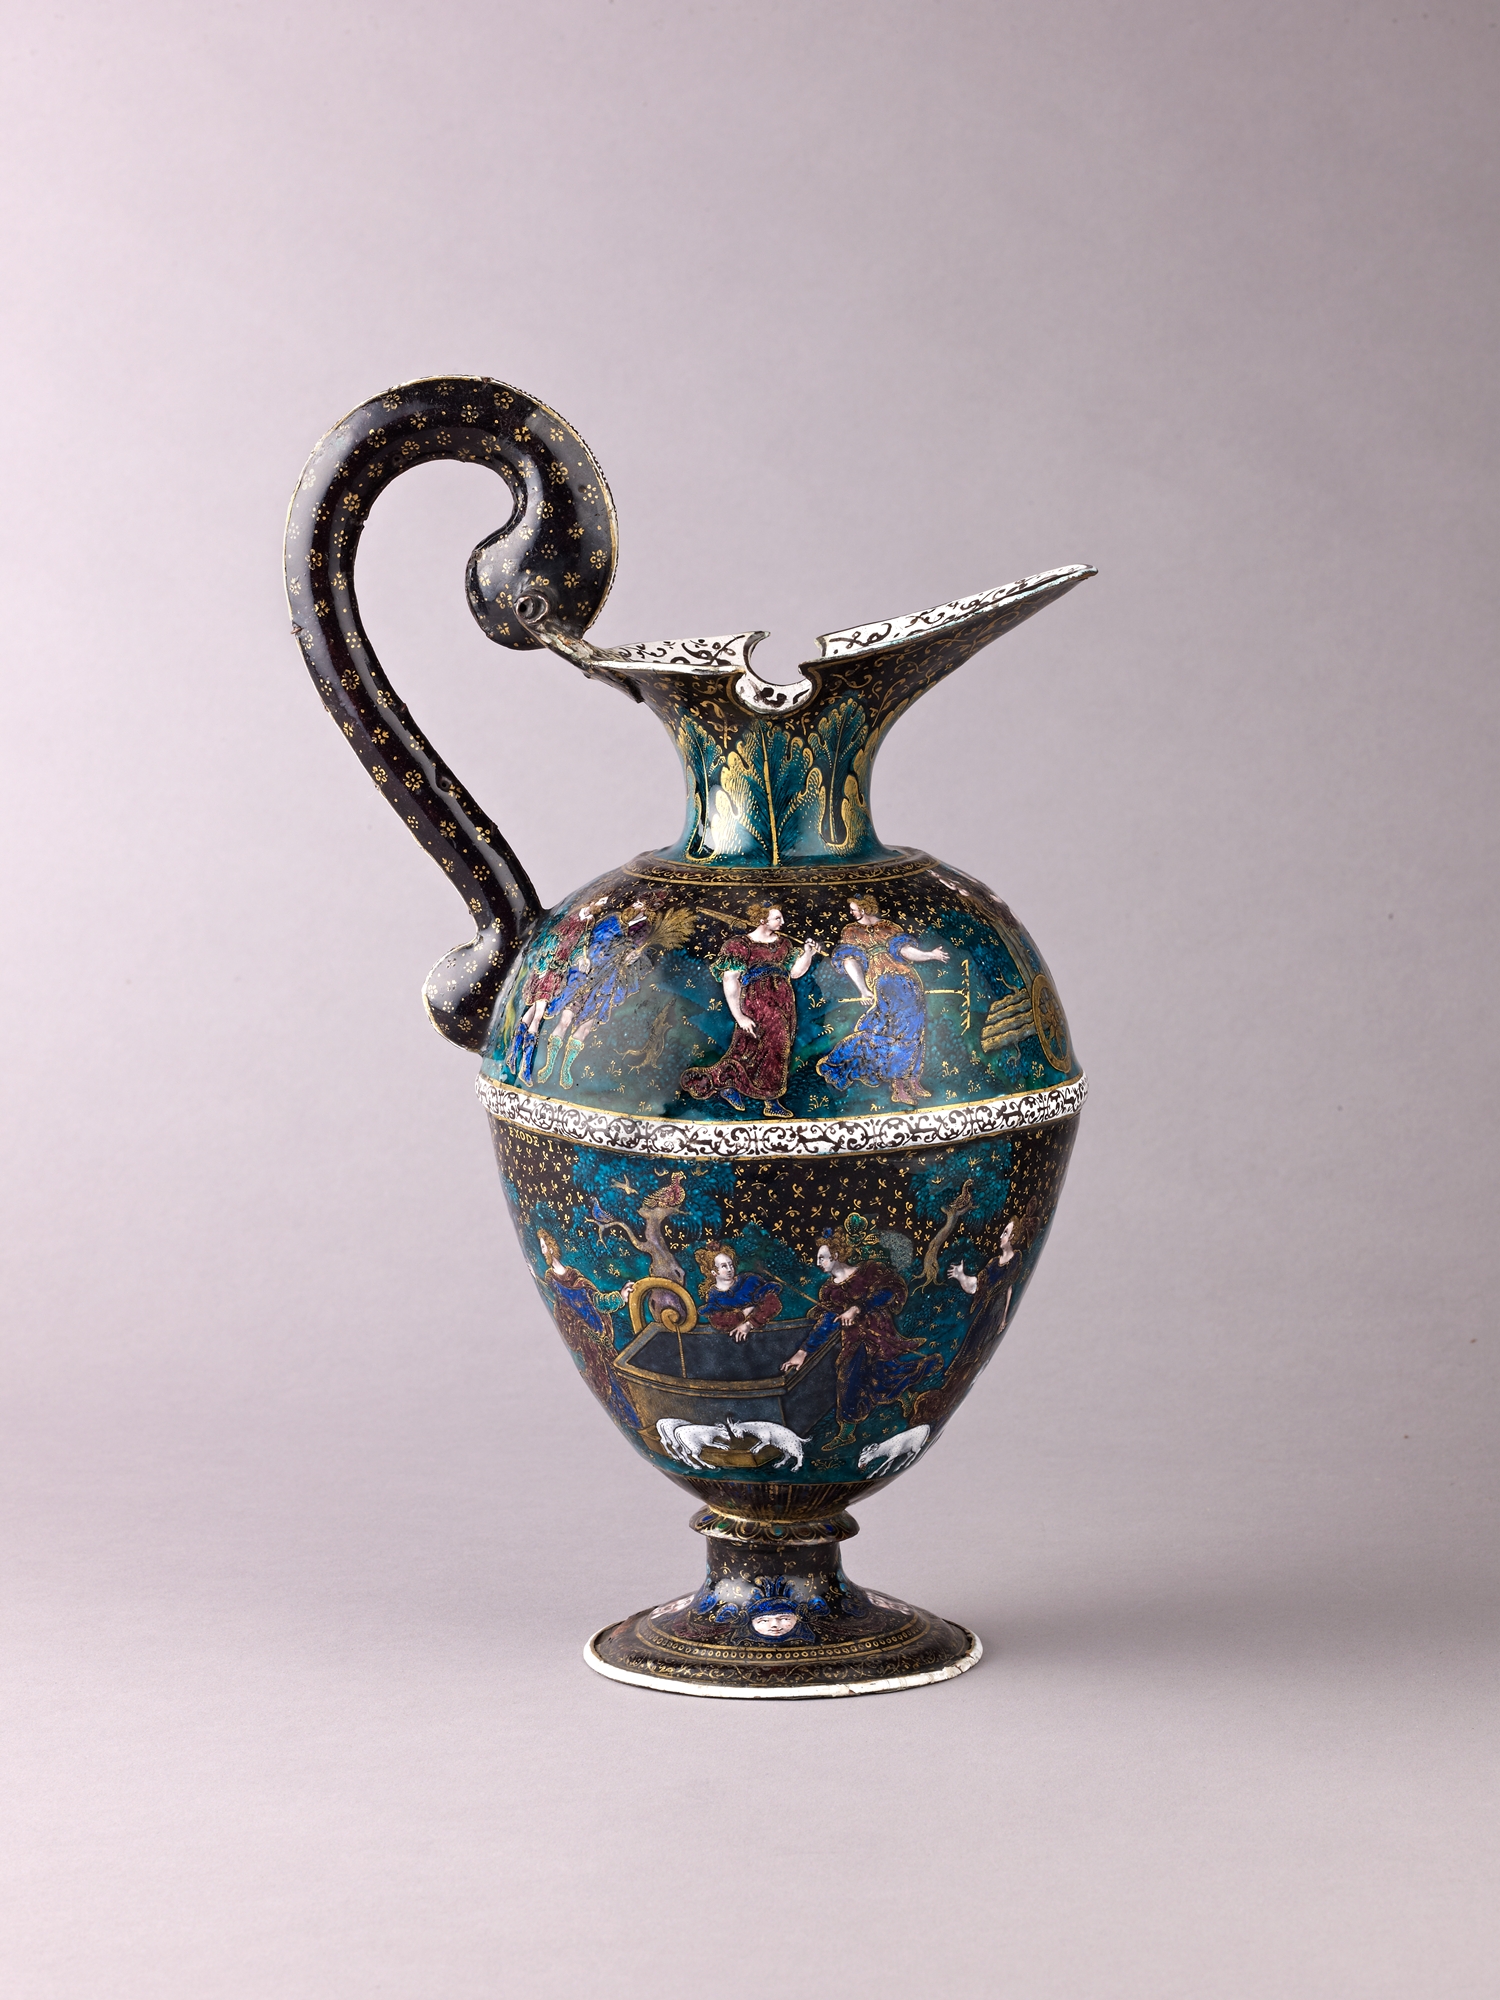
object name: ewer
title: Triumph of Ceres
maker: suzanne de court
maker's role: artist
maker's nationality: french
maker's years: 1575-1625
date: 1567-1633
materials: copper, enamel, gilt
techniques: painting, silvered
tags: men,women,ceres